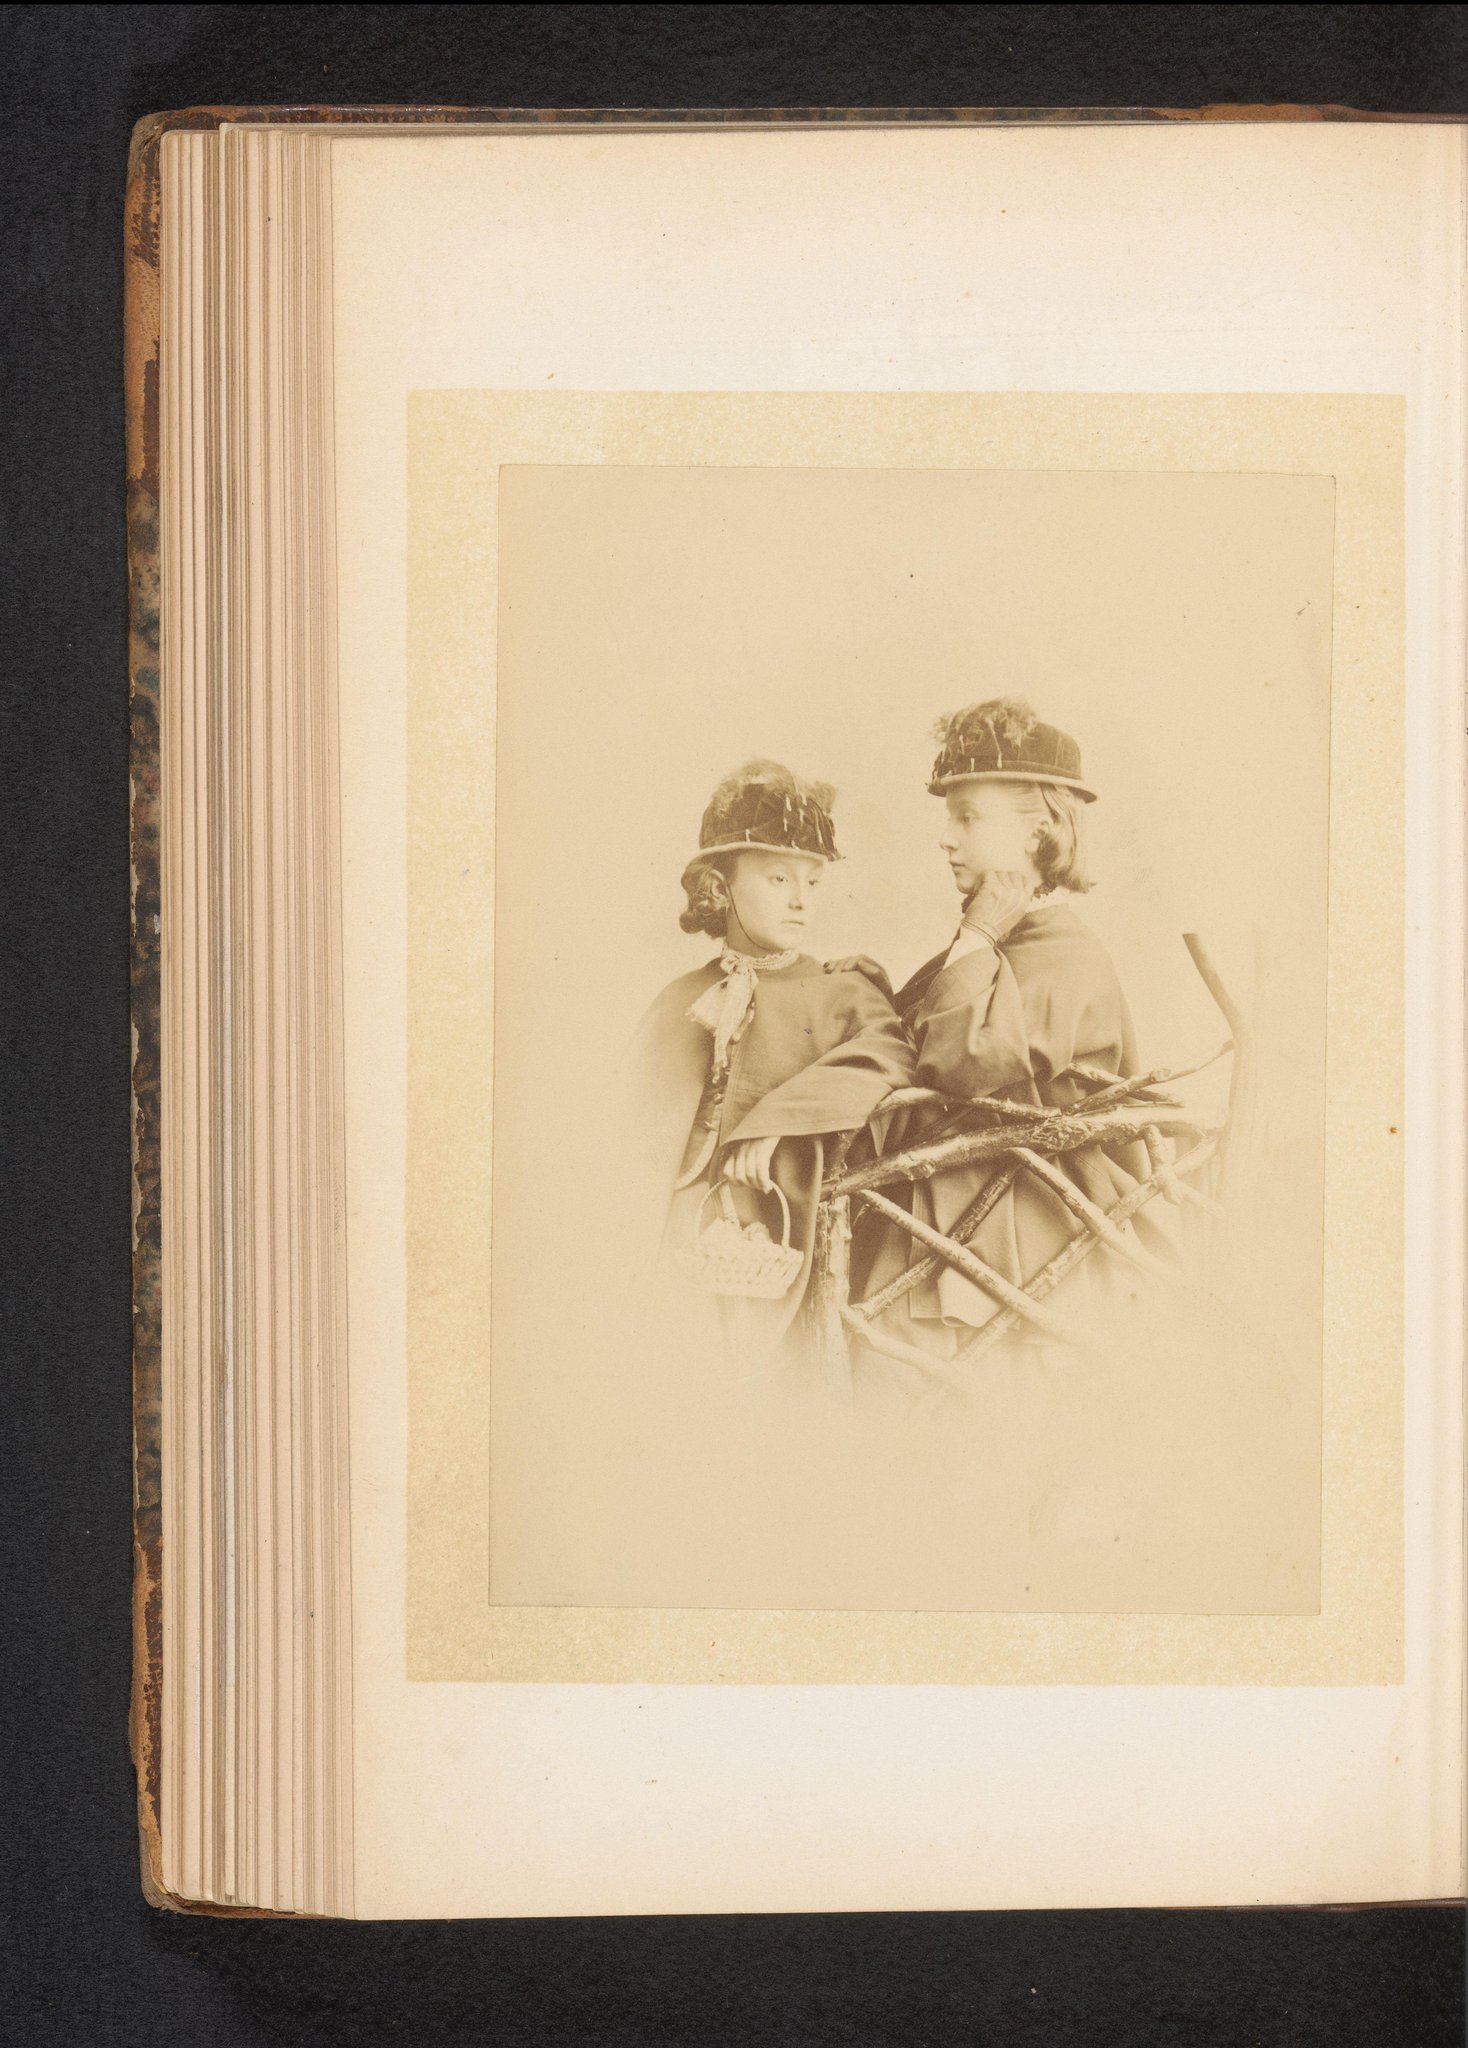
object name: page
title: Portret van twee onbekende jonge meisjes met hoeden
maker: william notman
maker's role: fotograaf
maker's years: 1826-1891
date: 1861-1866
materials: photographic support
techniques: albumen print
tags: historical persons not known by name - bb - woman, girl (child between toddler and youth)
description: Foto tegenover pagina 225, achter semi-transparante omslag.